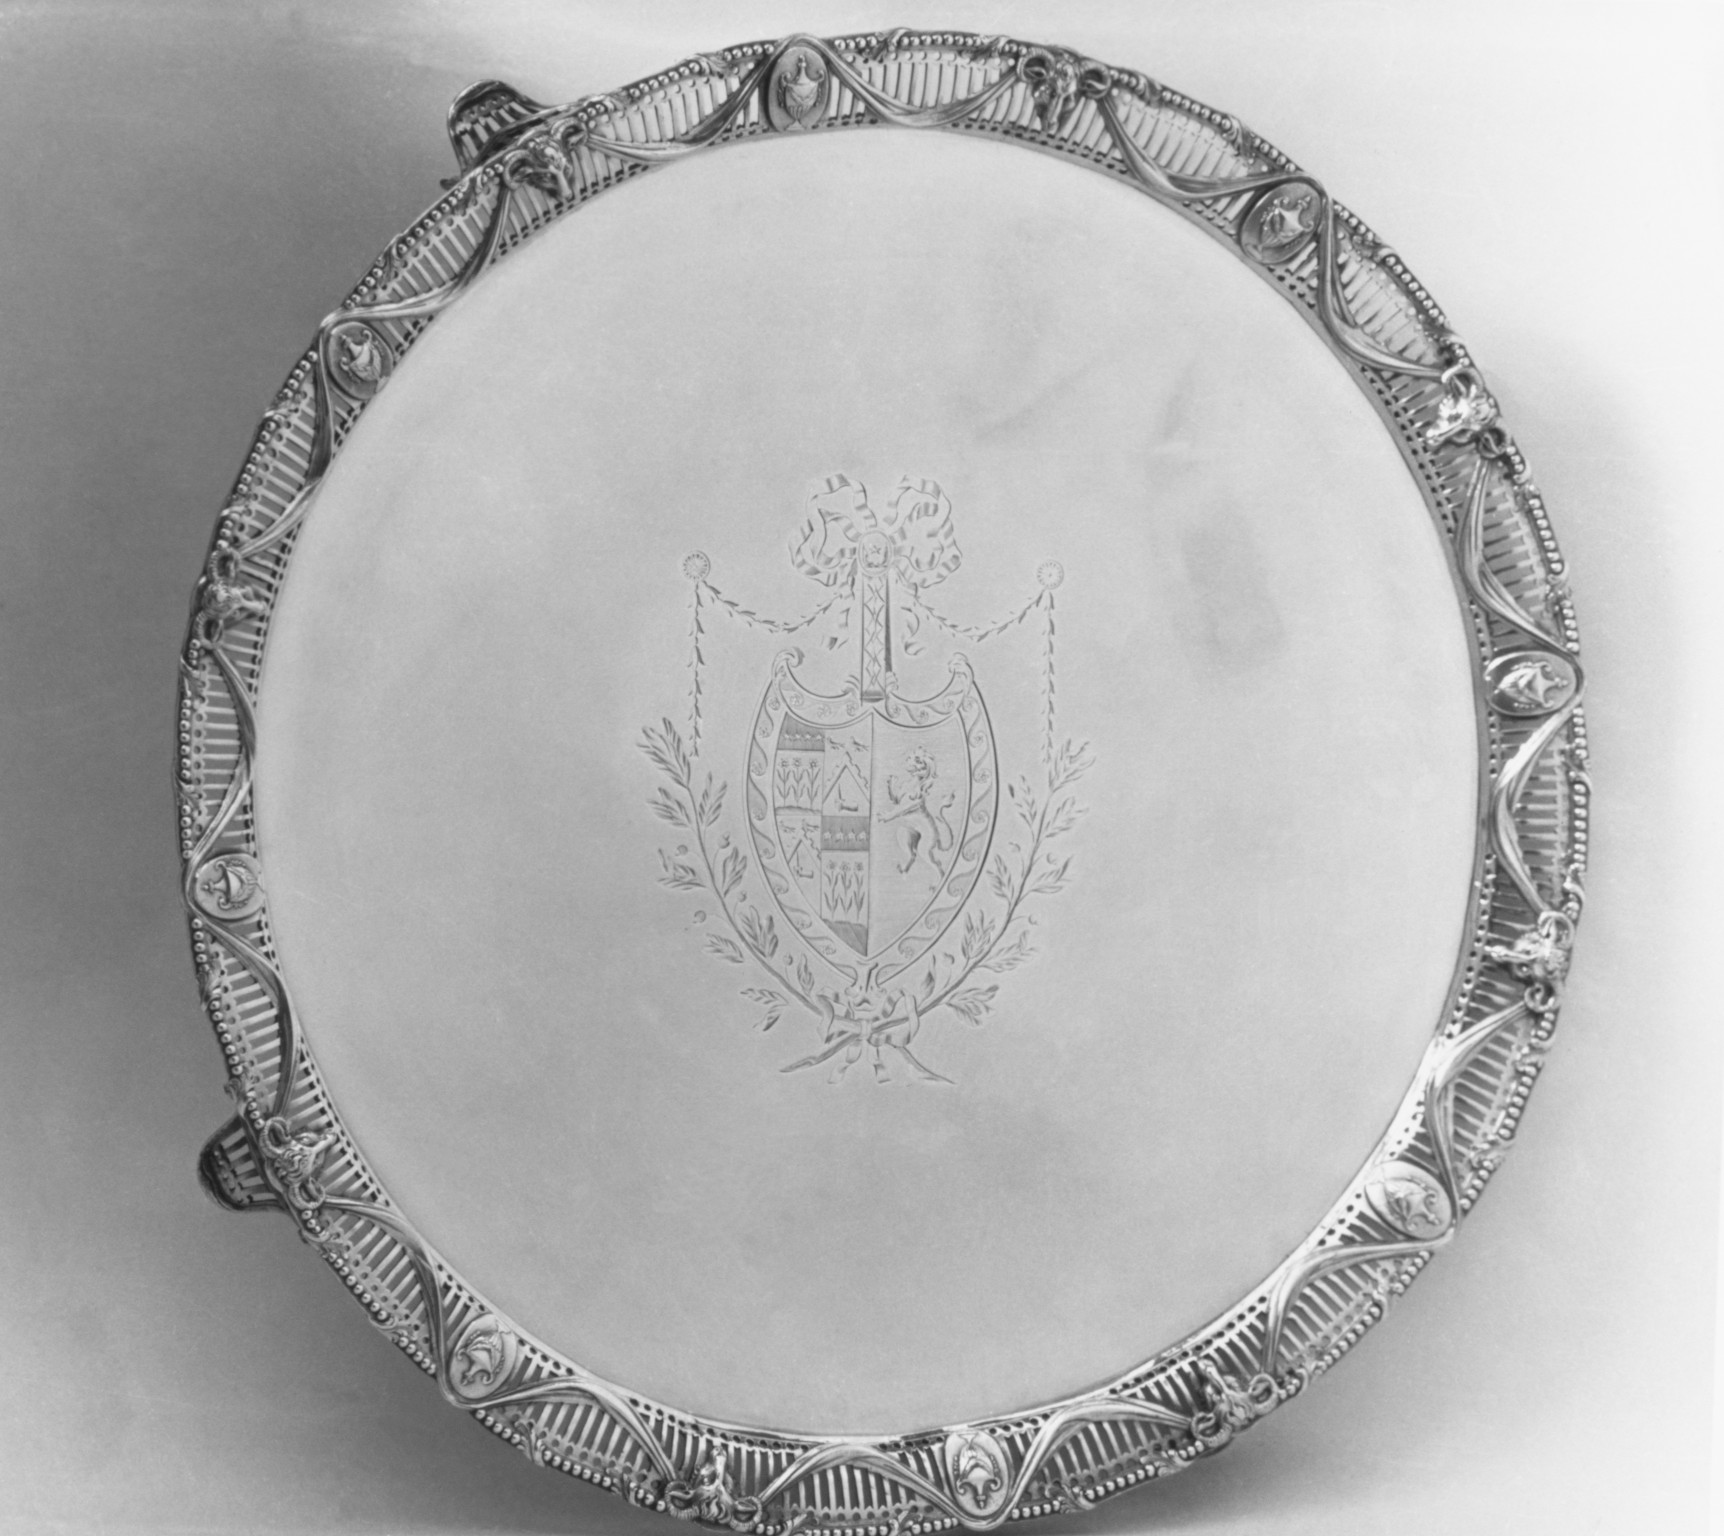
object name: salver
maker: w.c., london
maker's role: maker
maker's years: 1775-1776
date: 1775-1776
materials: silver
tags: coat of arms